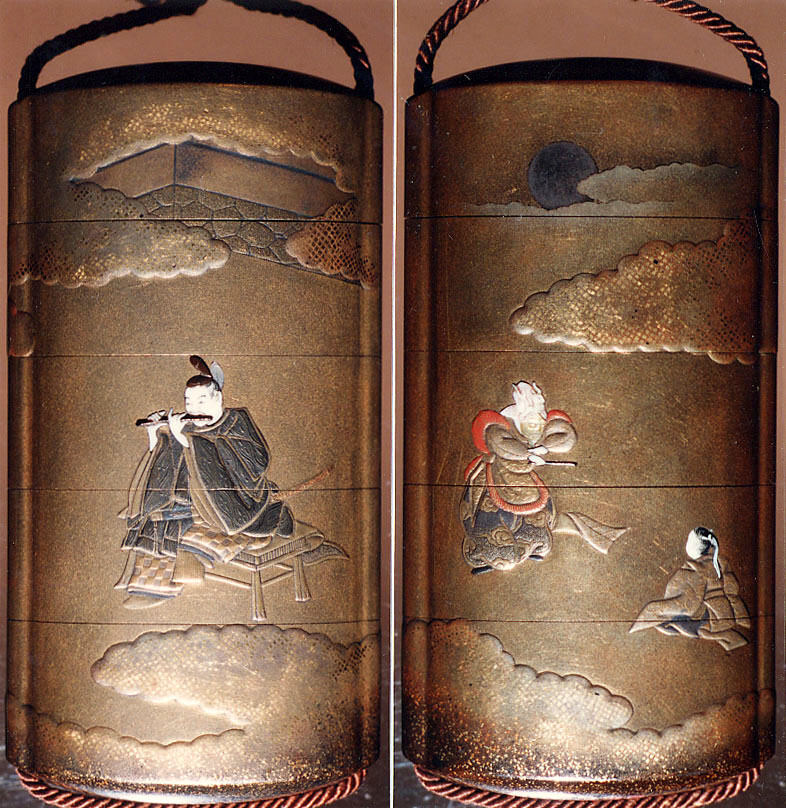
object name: inrō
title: Case (Inrō) with Design of Courtier Accompanying Raryōō (obverse); Nobleman Playing Flute (reverse)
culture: japanese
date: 1801-1900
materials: gold, lacquer, silver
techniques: maki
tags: men,flutes